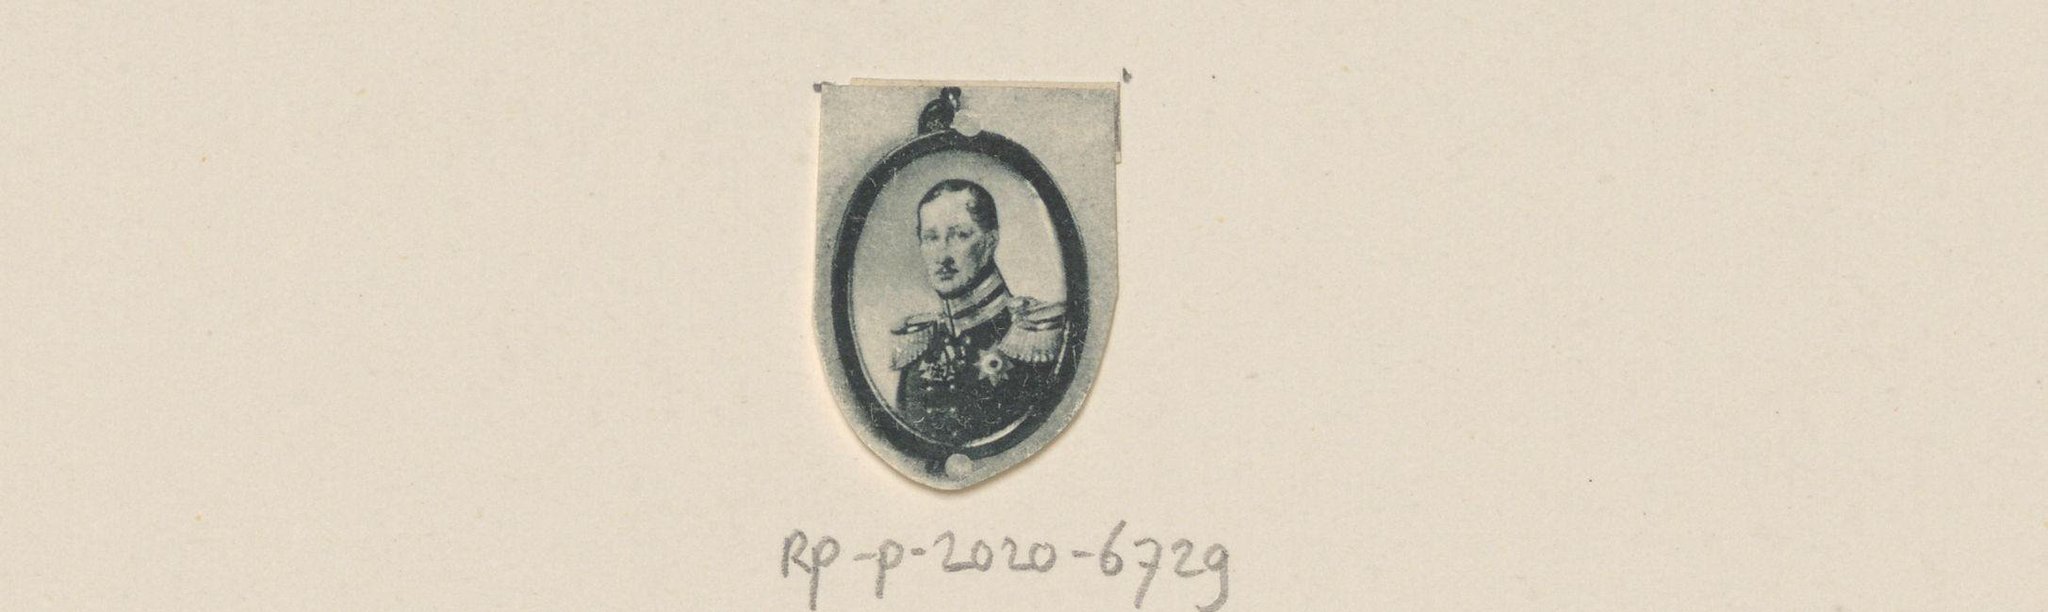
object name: photomechanical print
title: Portret van Frederik Willem III van Pruisen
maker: Anonymous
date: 1875-1930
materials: paper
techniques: photograph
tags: berlin, frederik willem iii koning van pruisen, ornament ~ medallion, historical persons, king